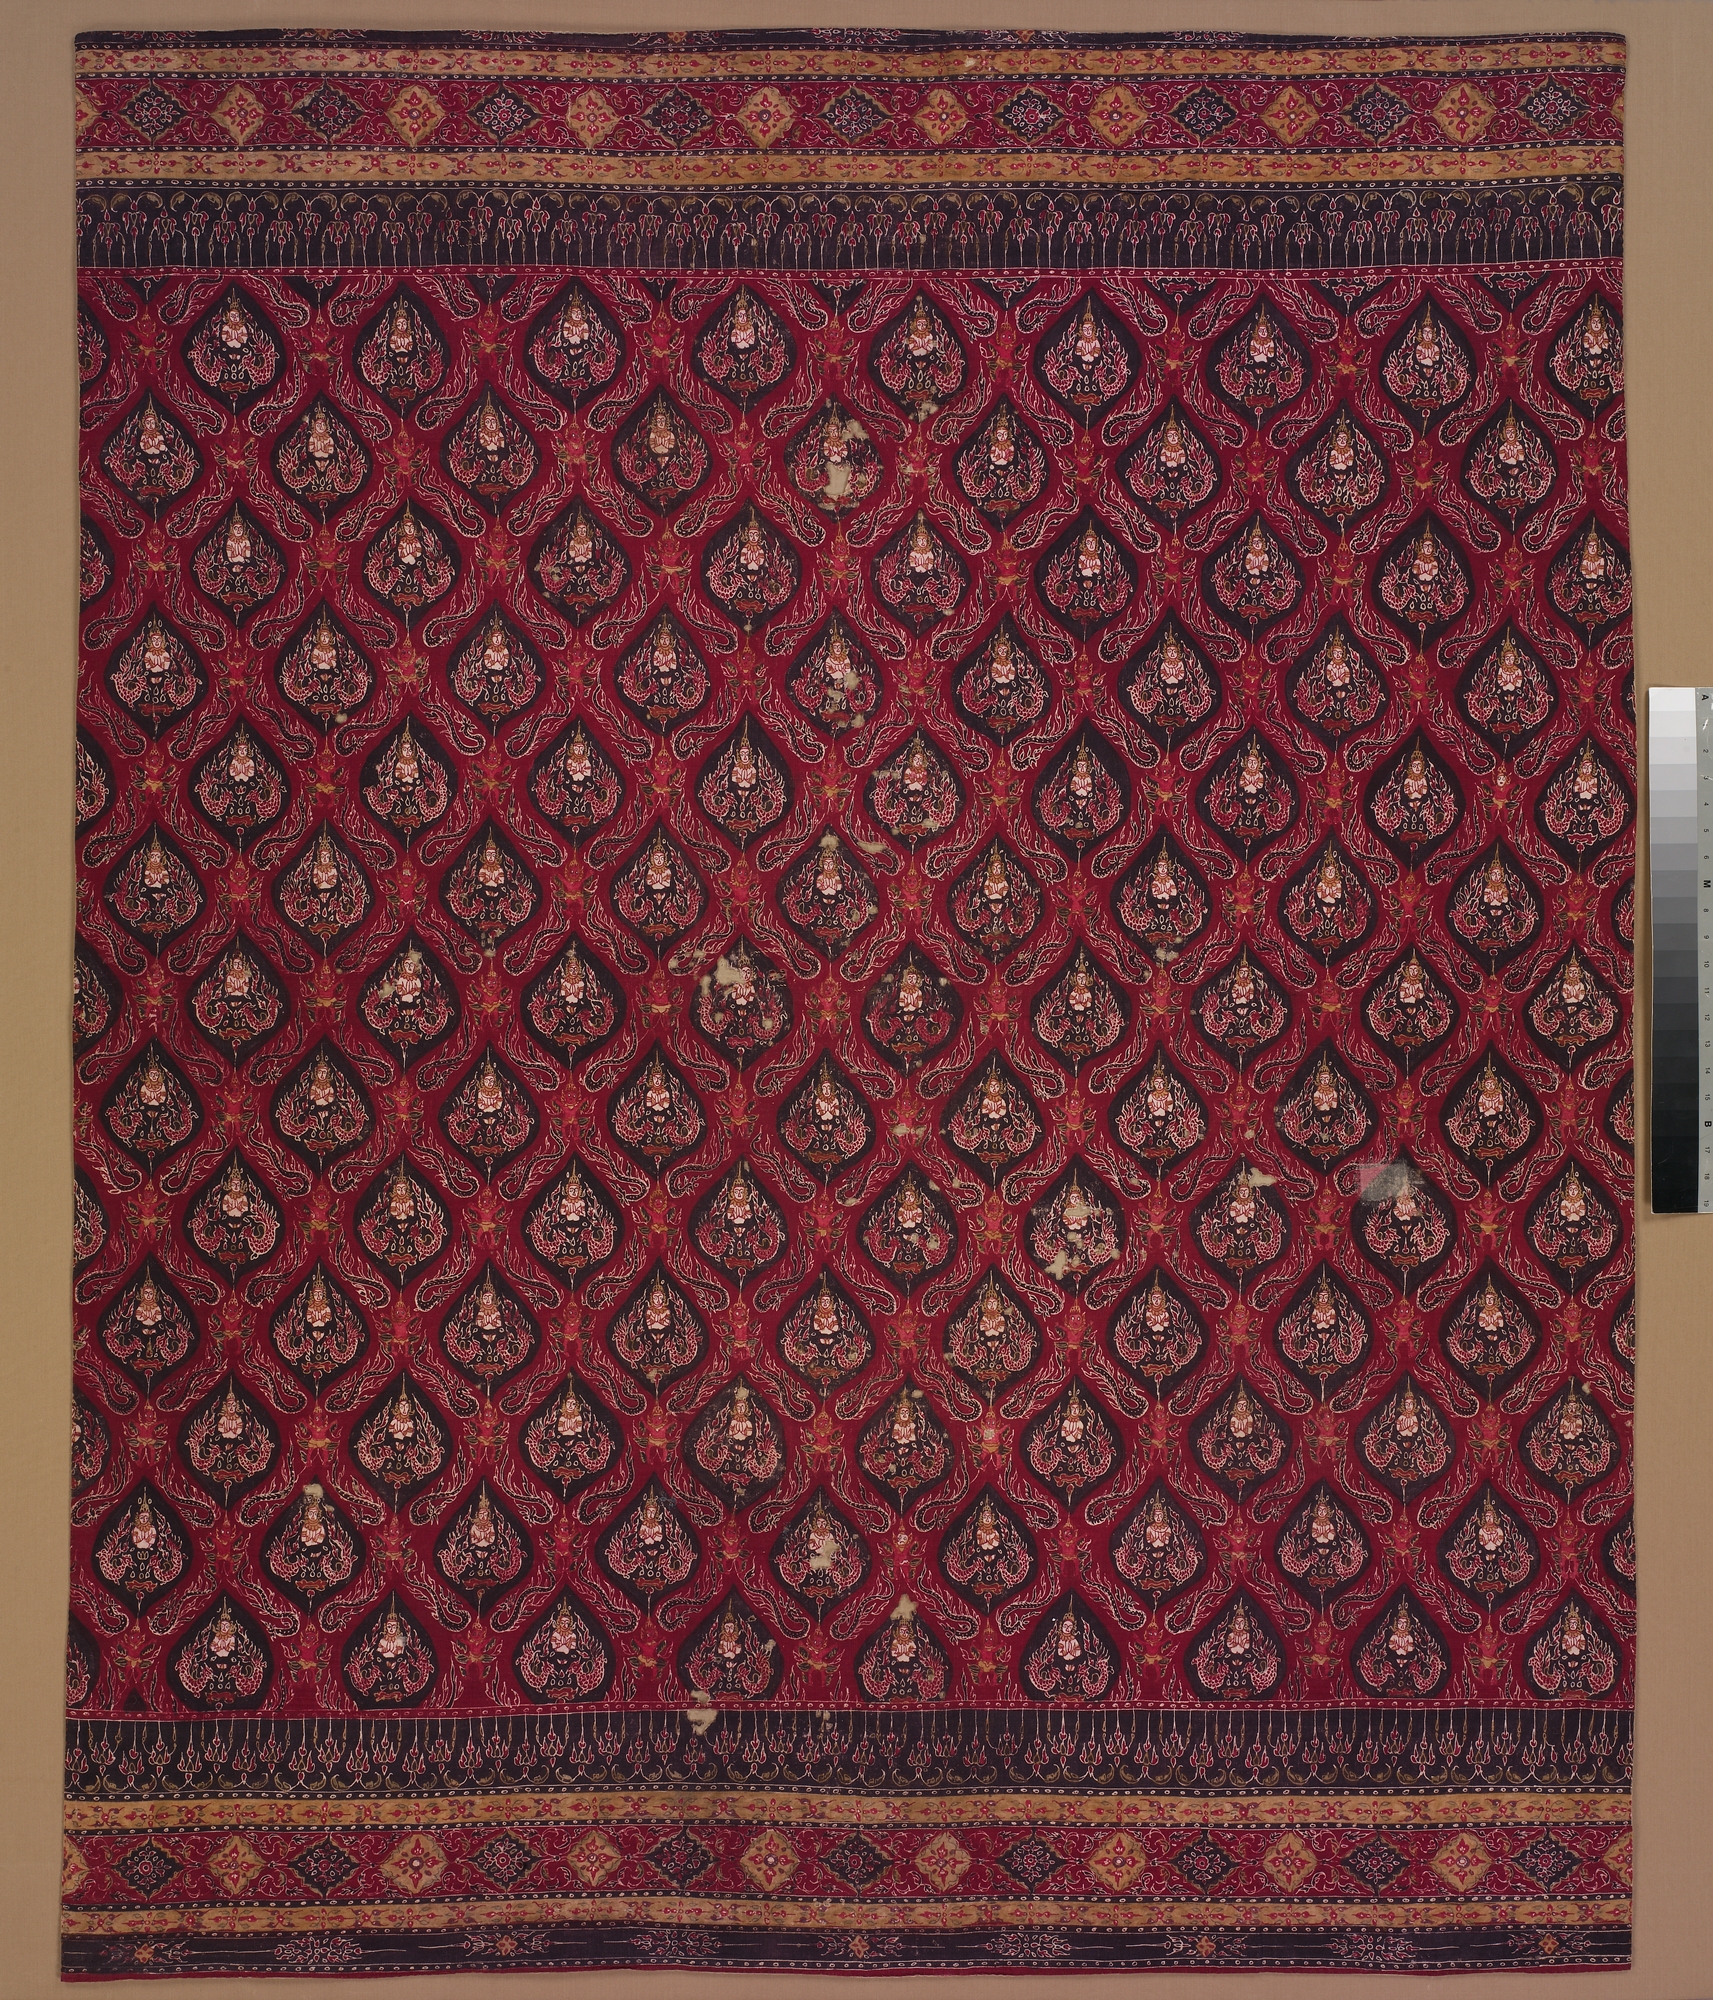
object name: textile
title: Painted Cotton with Celestial Deva Design in a Trellis Pattern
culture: indian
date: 1767-1900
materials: cotton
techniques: dyeing, painting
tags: dragons